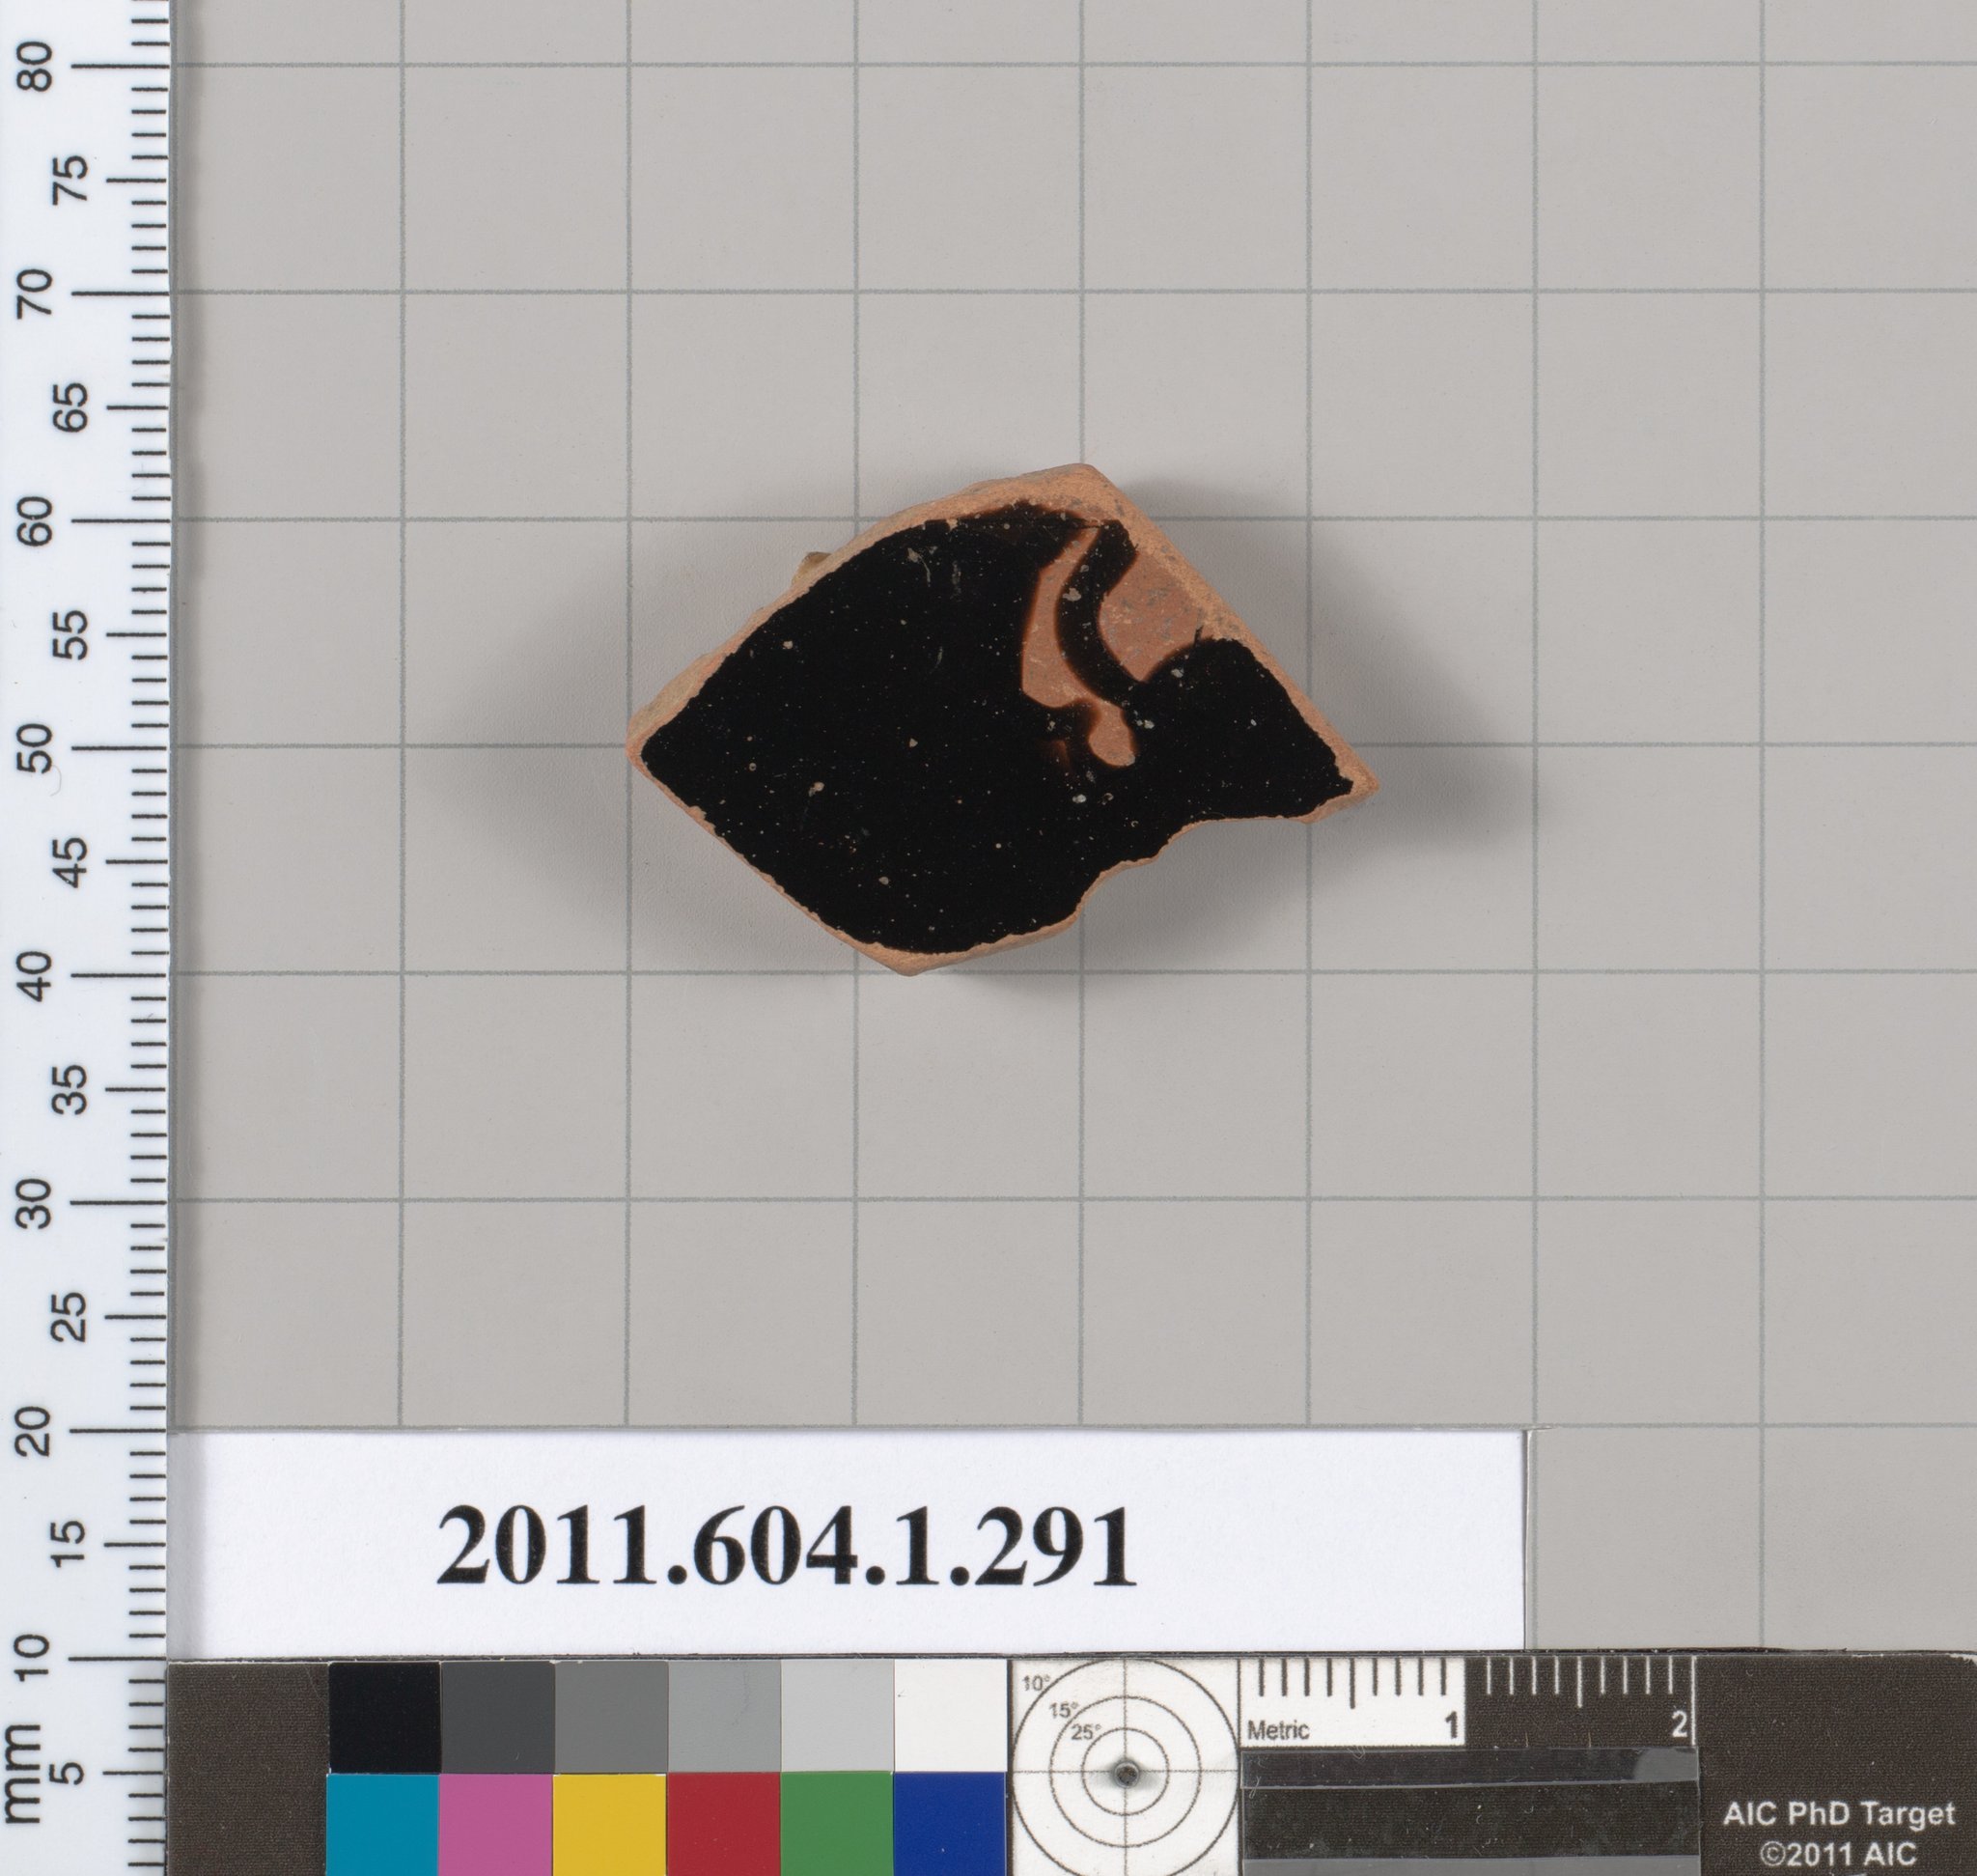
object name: kylix fragment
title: Terracotta fragment of a kylix (drinking cup)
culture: greek, attic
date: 475-451 BCE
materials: terracotta